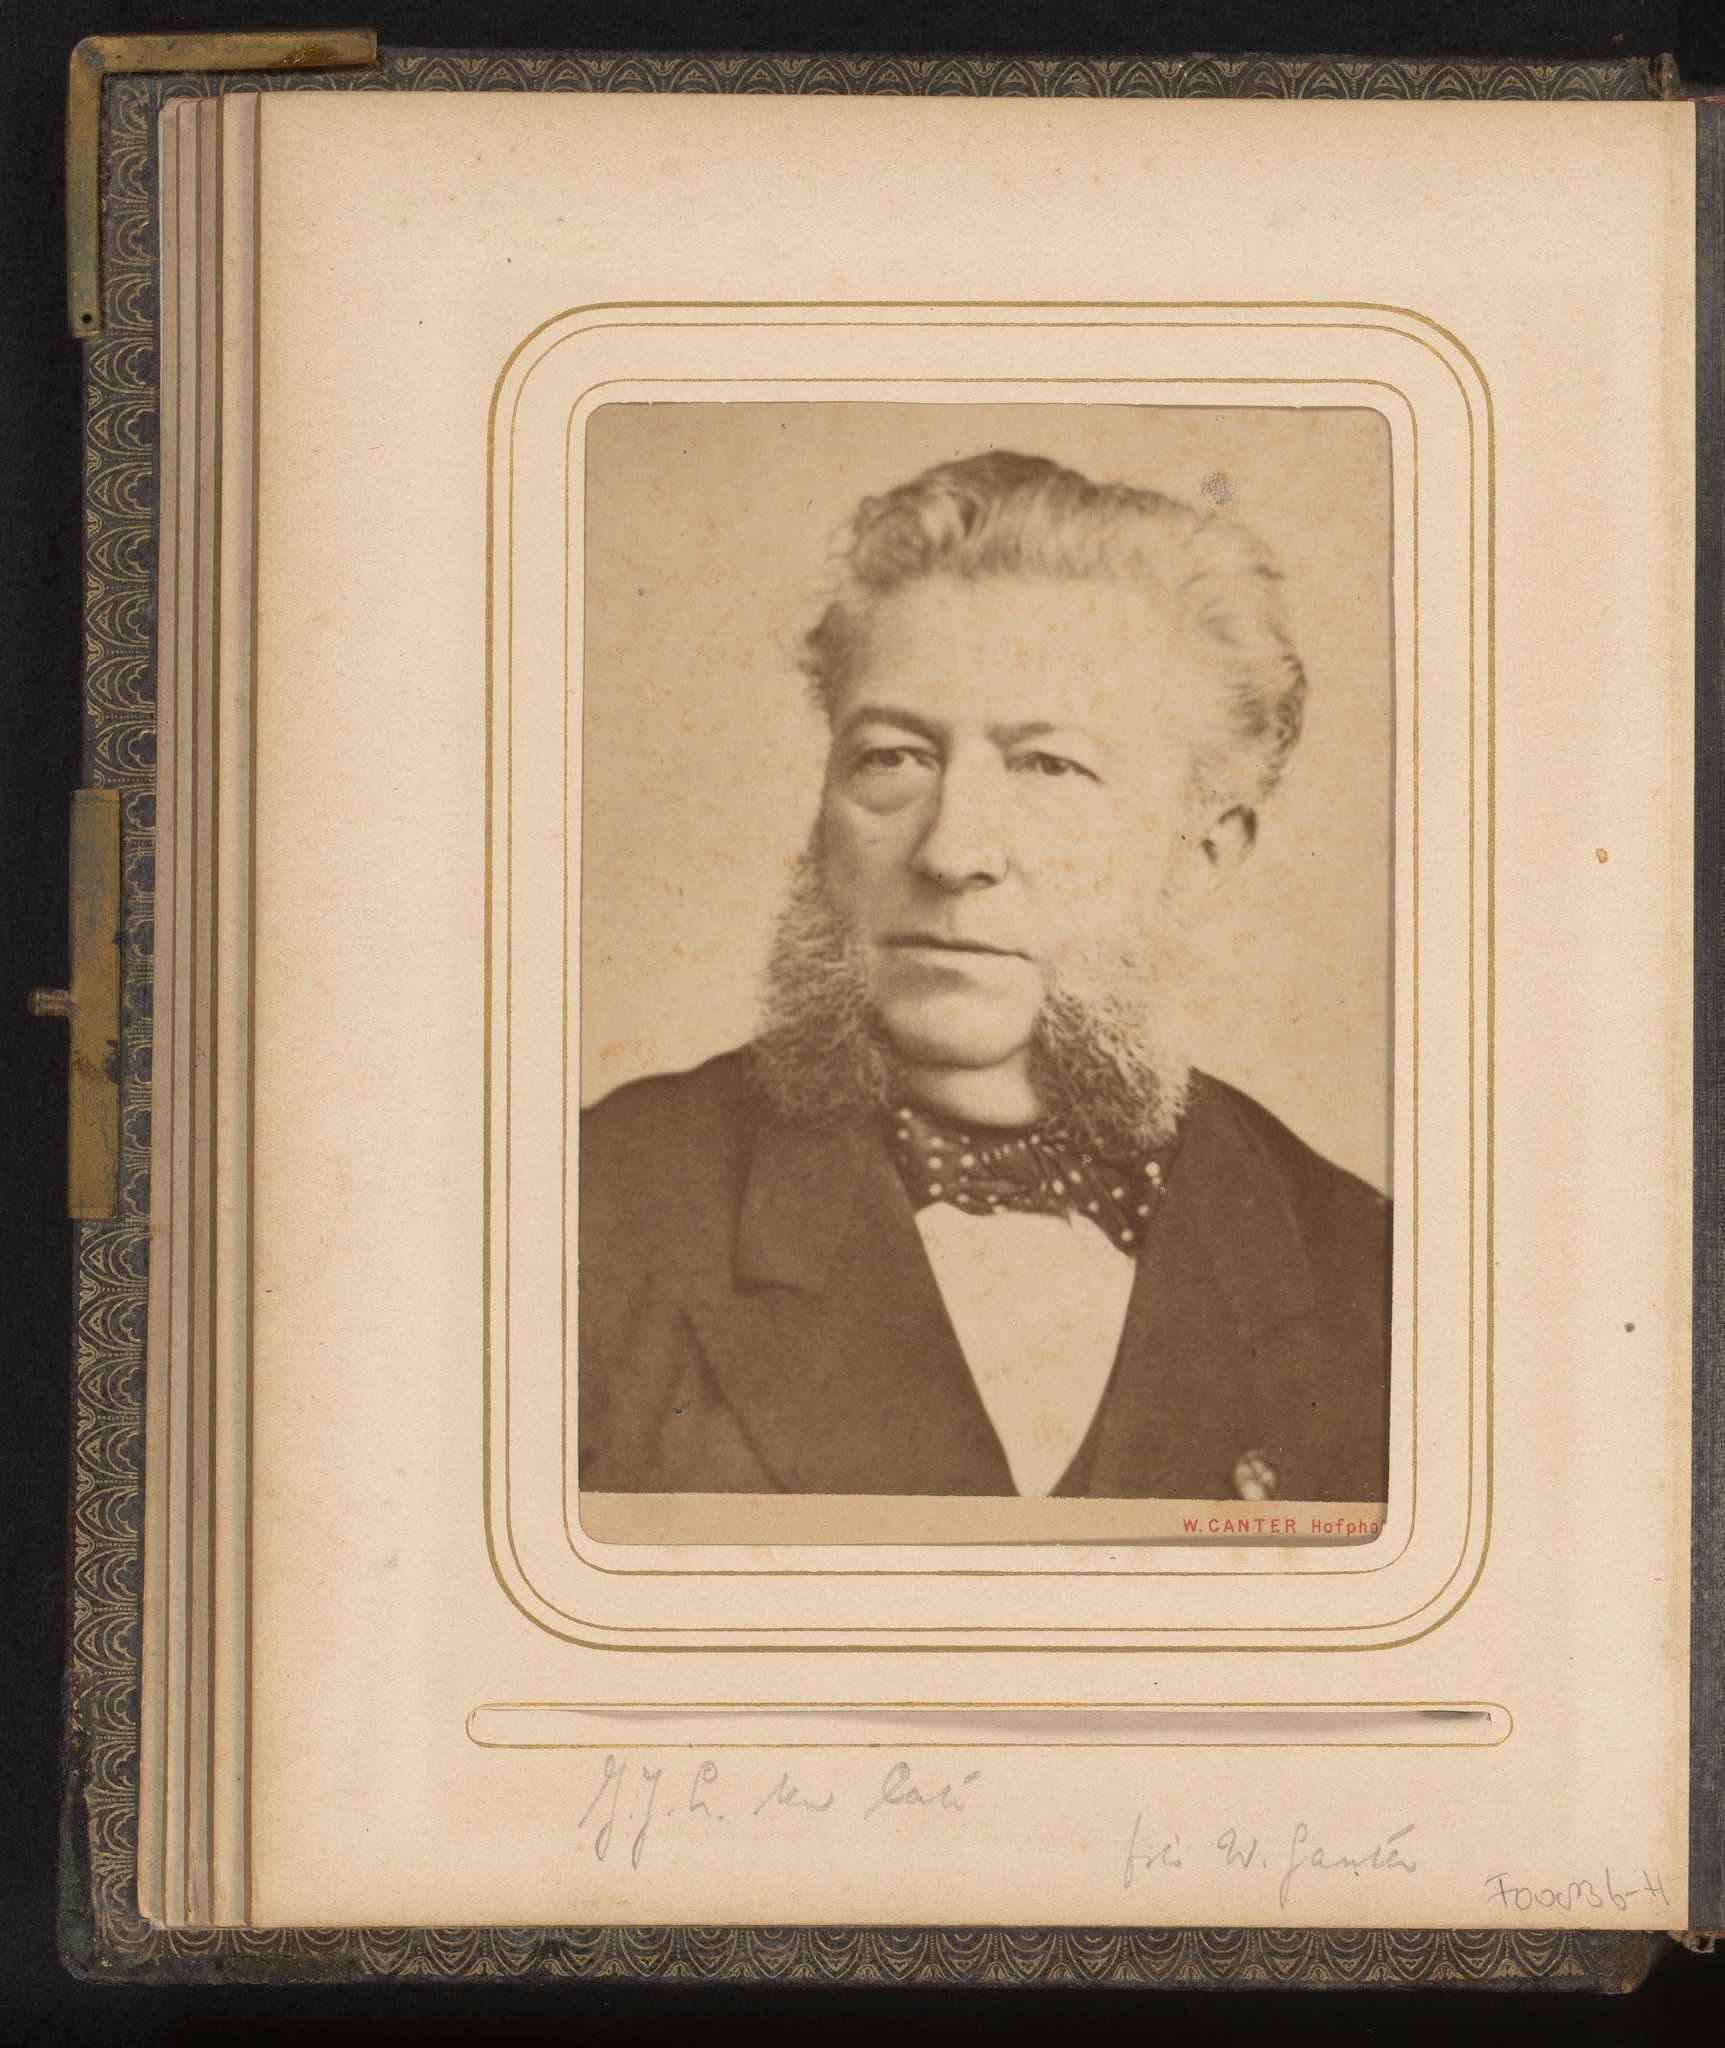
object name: album leaf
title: Portret van Jan Jacob Lodewijk ten Kate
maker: w. canter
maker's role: fotograaf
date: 1877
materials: cardboard, photographic support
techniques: albumen print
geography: the hague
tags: the hague, amsterdam, jan jakob lodewijk ten kate, historical persons, writer, poet, author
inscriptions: date: ‘31 december 1877’, annotation: ‘J.J.L. ten Kate/ foto W. Canter’